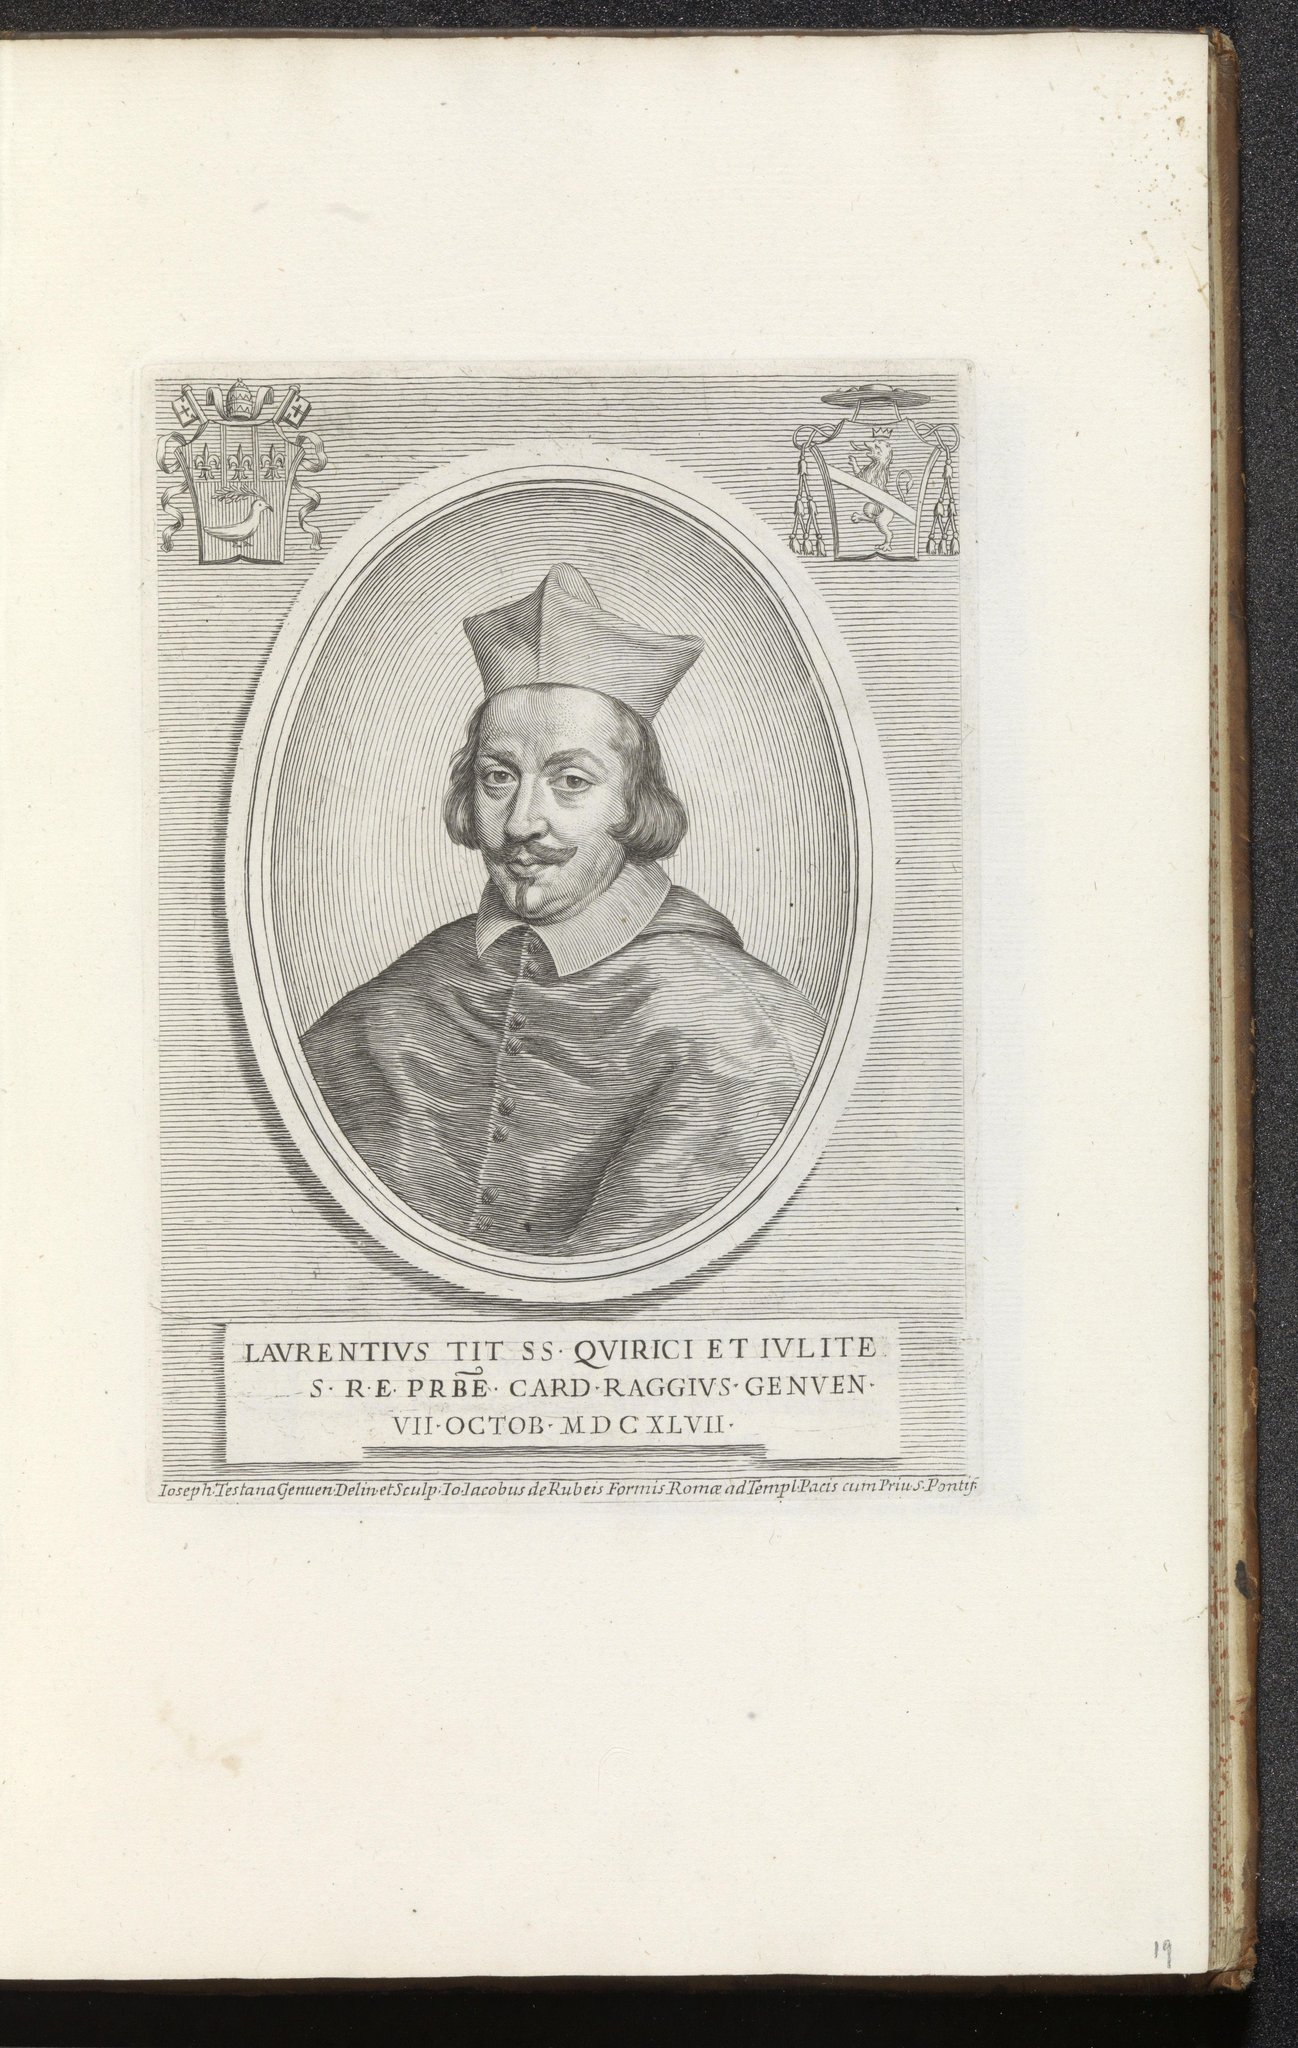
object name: album leaf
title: Portret van kardinaal Lorenzo Raggi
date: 1658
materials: paper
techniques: engraving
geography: rome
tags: cardinal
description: Portret van kardinaal Lorenzo Raggi. Linksboven het wapen van paus Innocentius X en rechtsboven het wapen van Odescalchi. Onderaan een onderschrift in het Latijn. De prent maakt deel uit van een album.